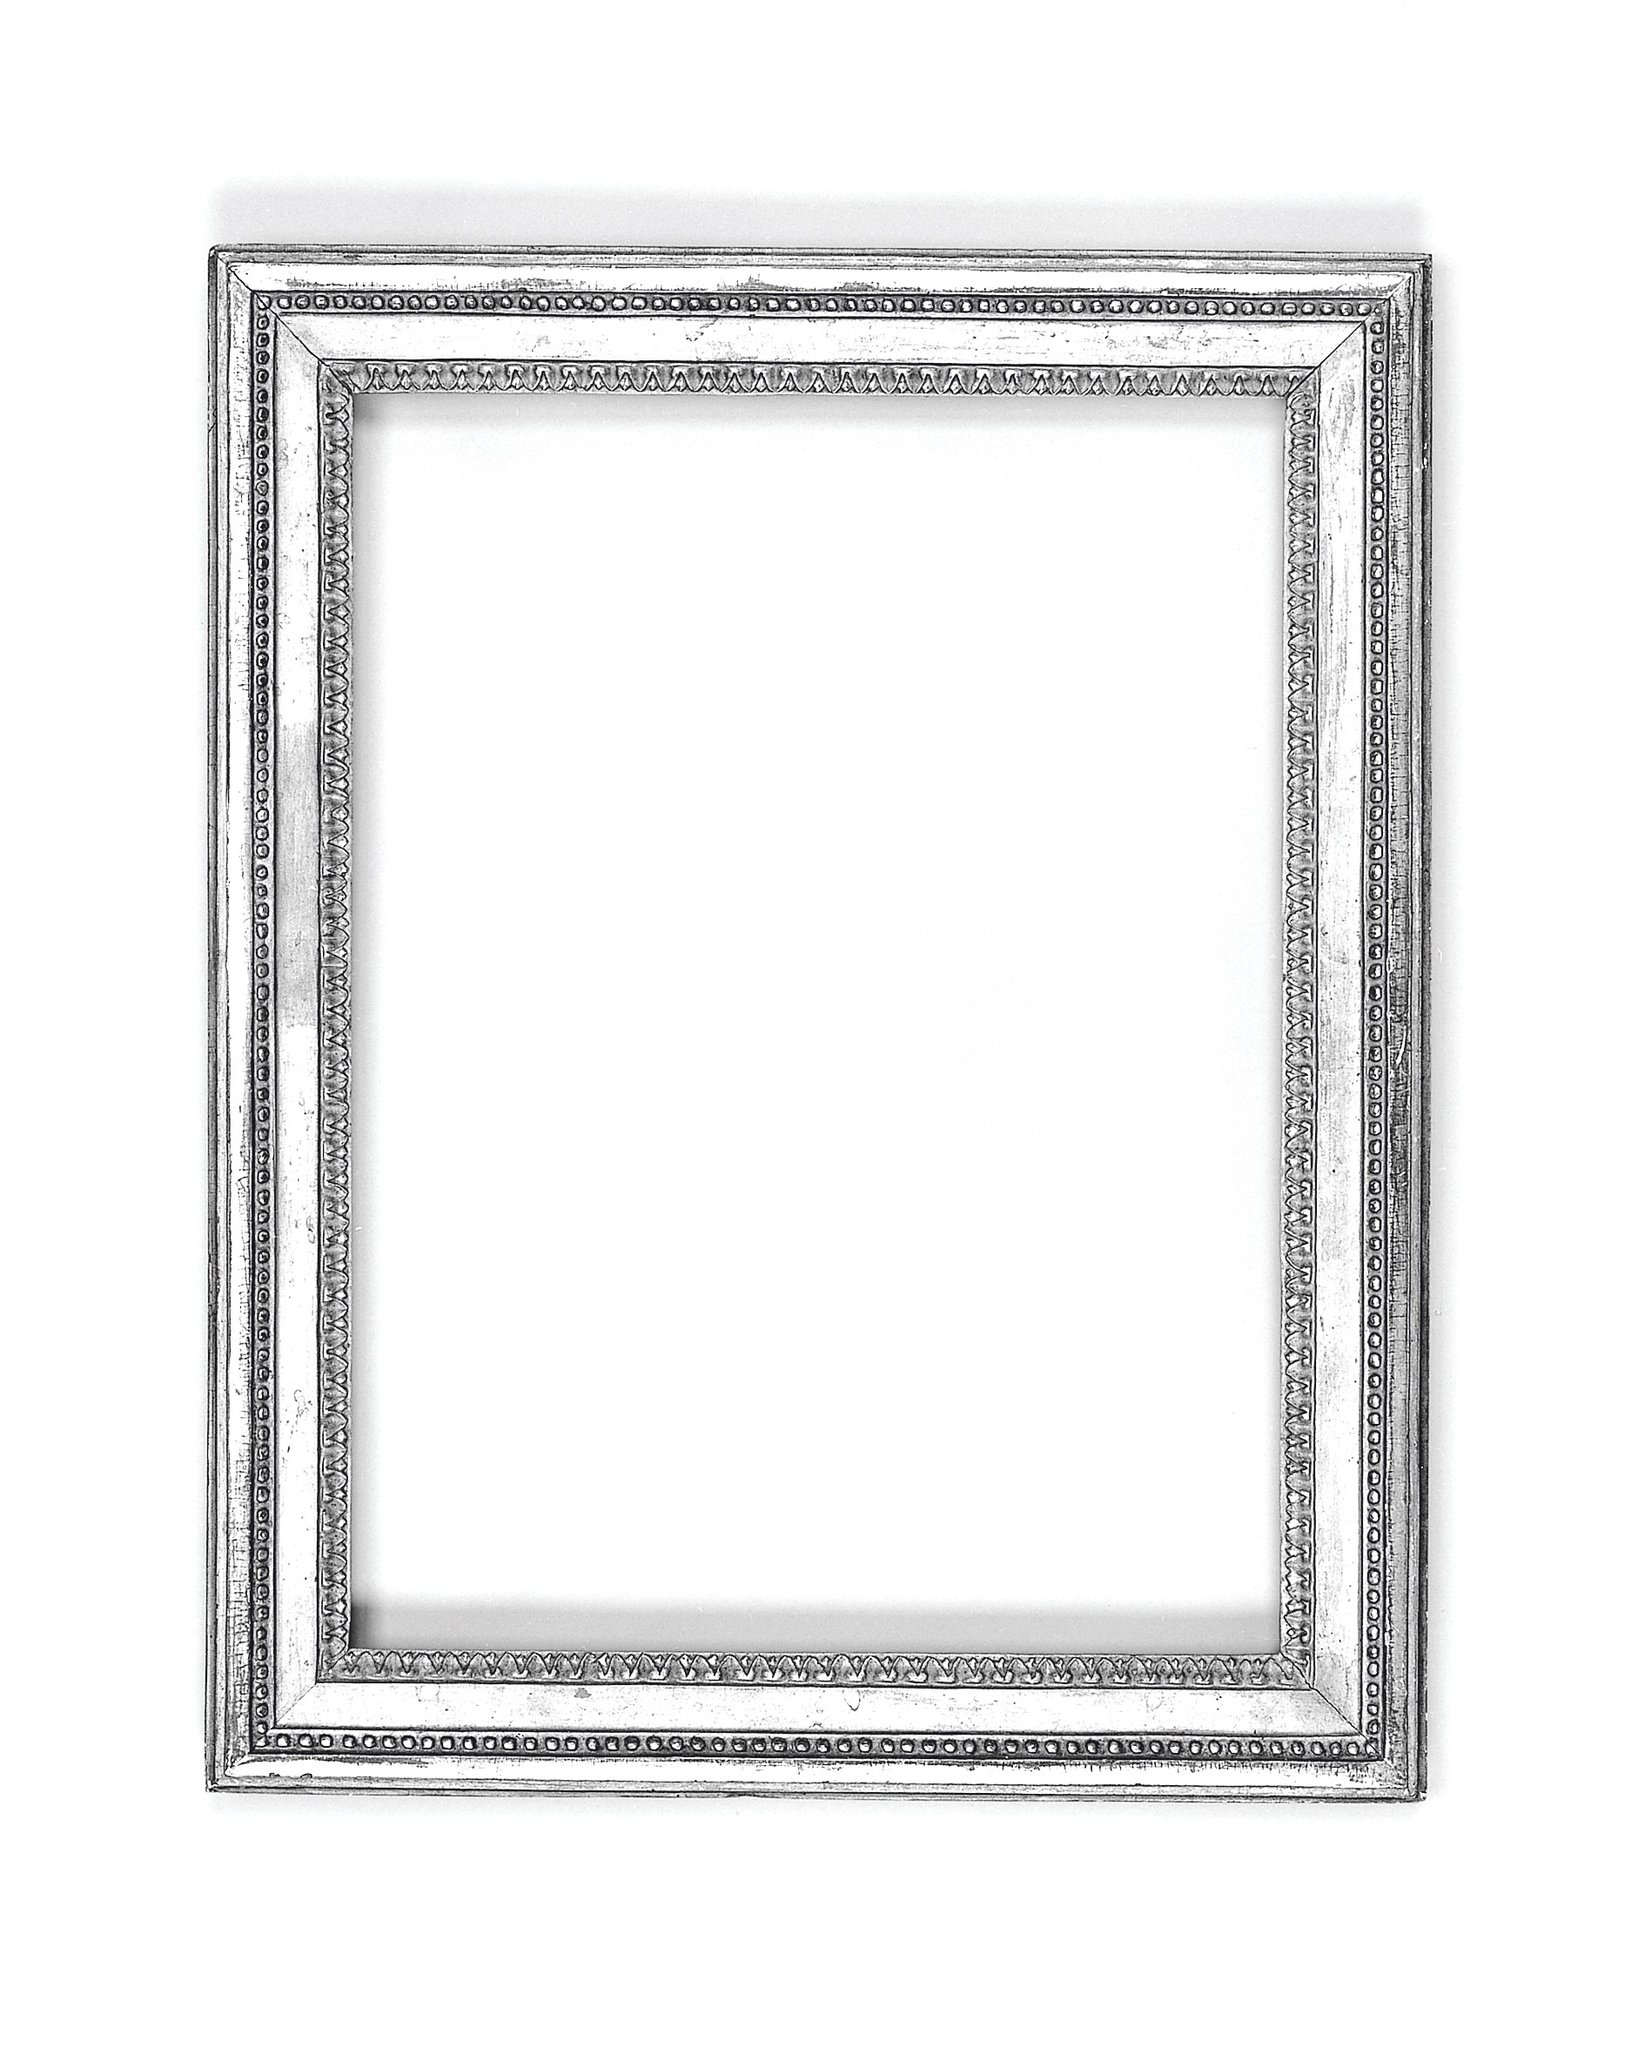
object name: frame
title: Cassetta frame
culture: french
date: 1780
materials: wood